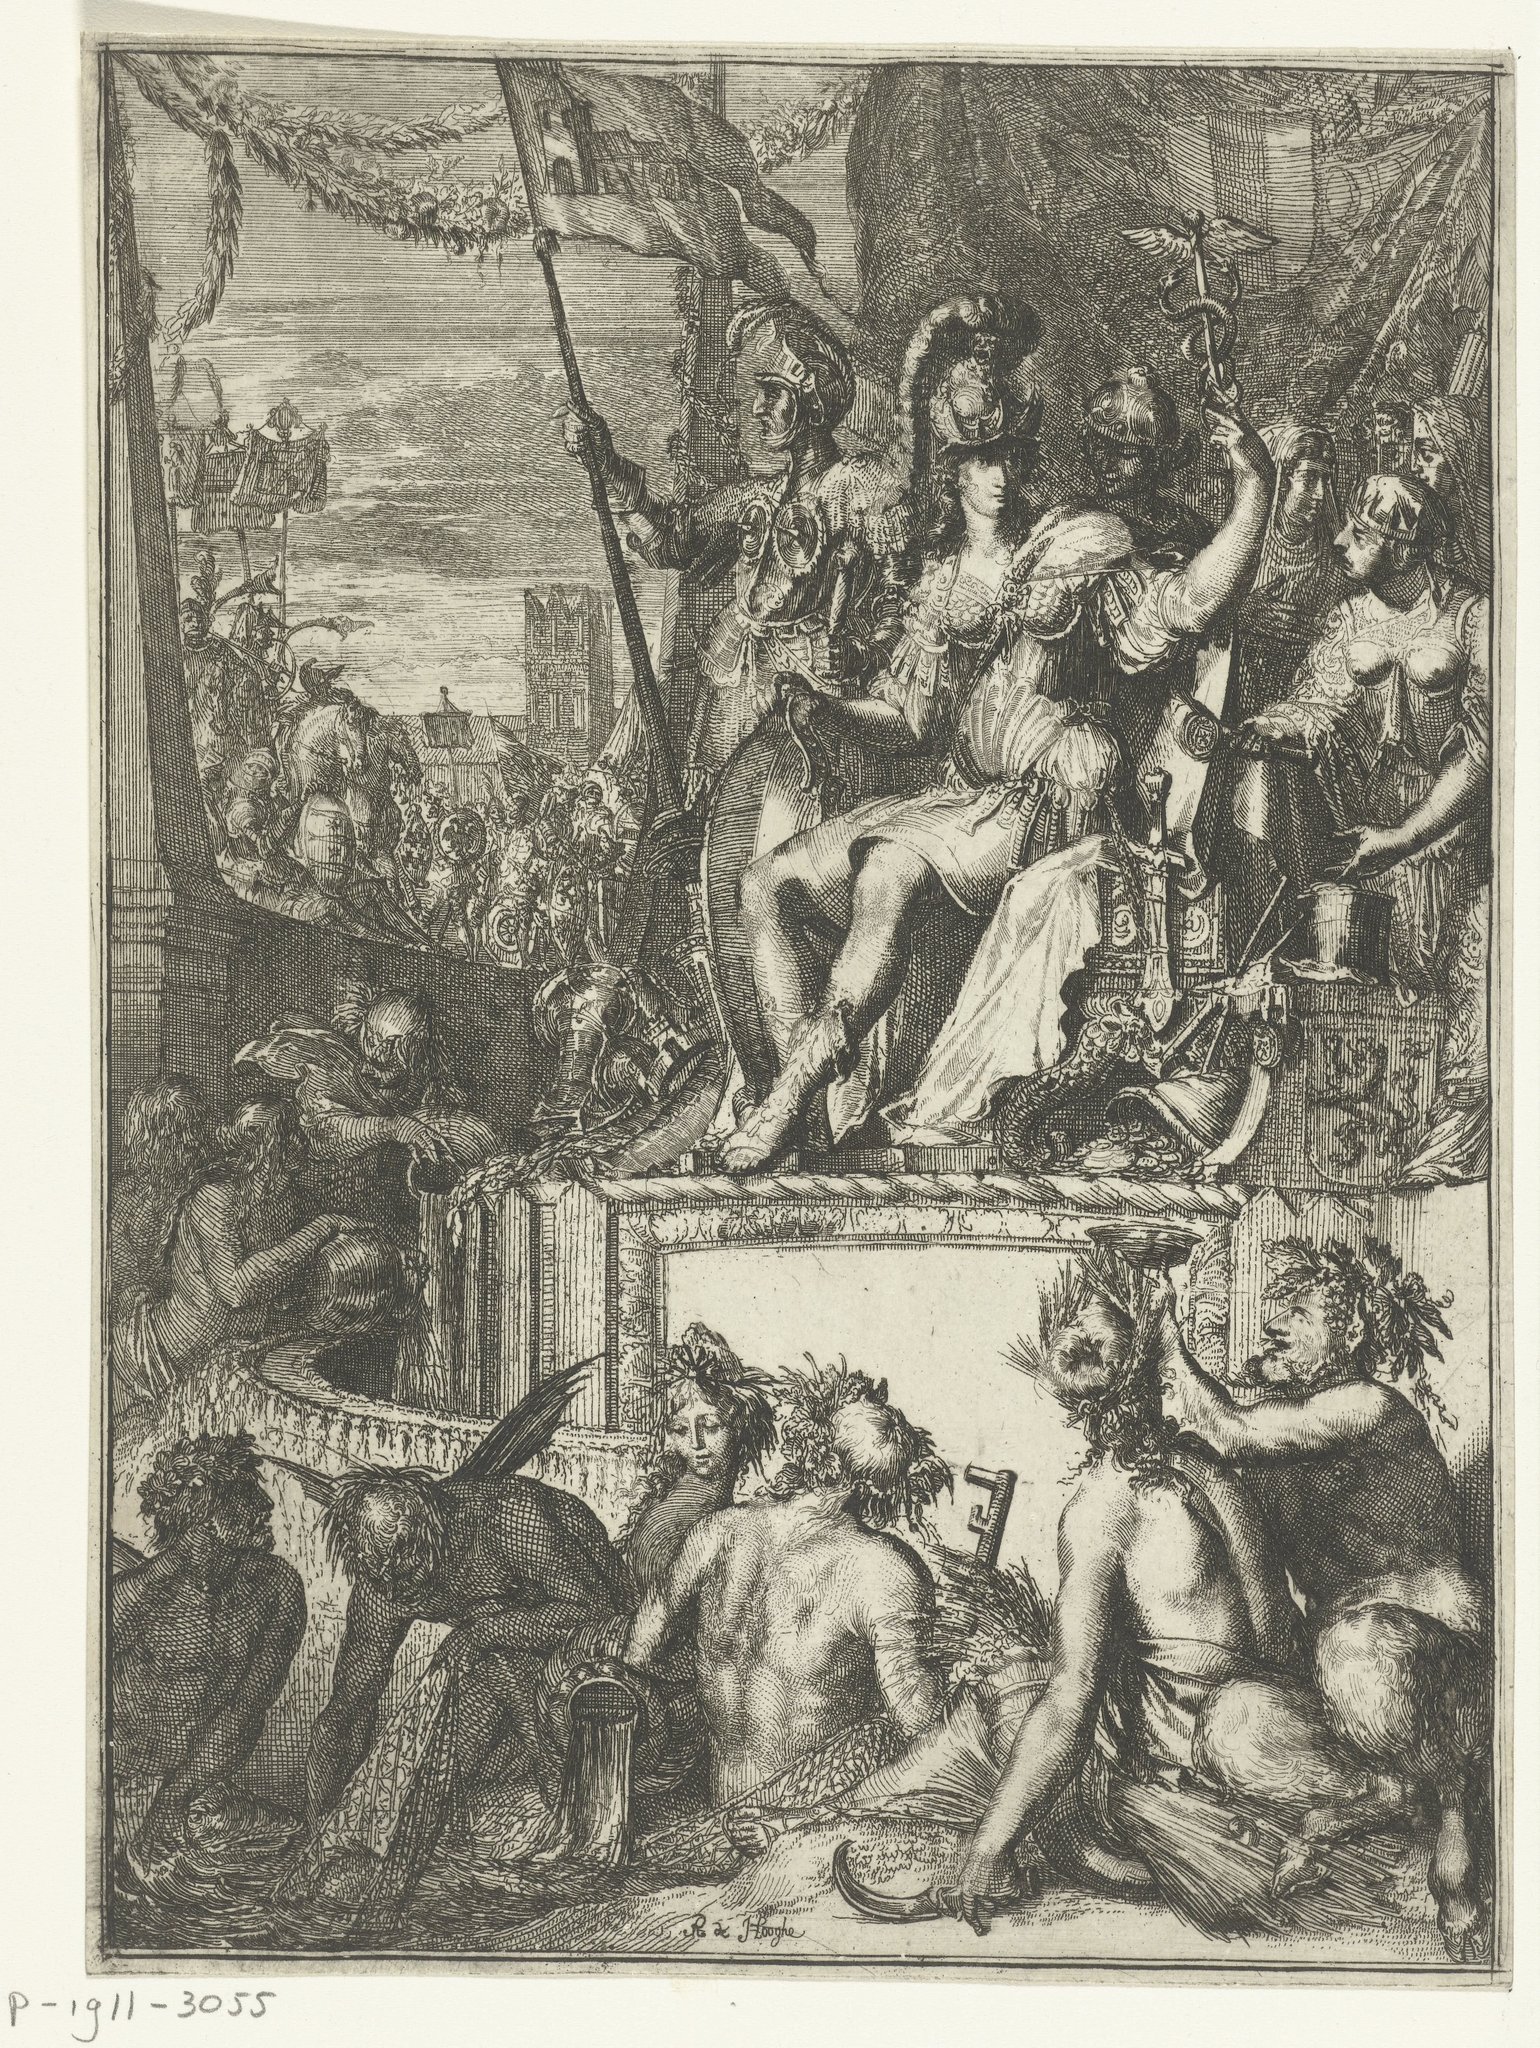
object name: print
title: Allegorische voorstelling van de (zee)handel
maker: romeyn de hooghe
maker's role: draughtsman, goldsmith, painter, print maker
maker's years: 1645-1708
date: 1655-1708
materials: paper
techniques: etching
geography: netherlands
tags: commercial fishery, river-gods, personification of agriculture, 'agricultura'; 'agricoltura', 'studio dell'agricoltura' (ripa), caduceus (staff with two snakes, attribute of mercury), allegory of trade; 'commertio della vita humana' (ripa), viticulture, wine-growing; vintage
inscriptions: collector's mark: Lugt 2228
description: Op een verhoging zit een dame (?) met een helm in de vorm van een schip op het hoofd, een caduceus in de hand. Naast haar staat een man met een vaandel waarop een kerk prijkt. Aan haar voeten zitten figuren die de visserij, de landbouw en de wijnbouw verbeelden.